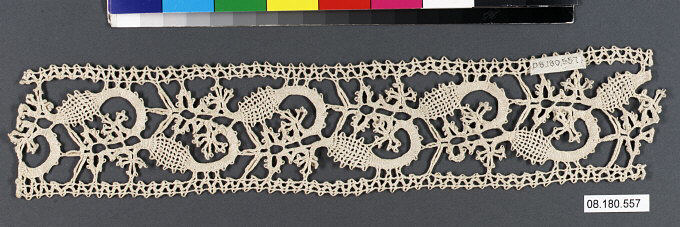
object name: fragment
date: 1601-1700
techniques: lace